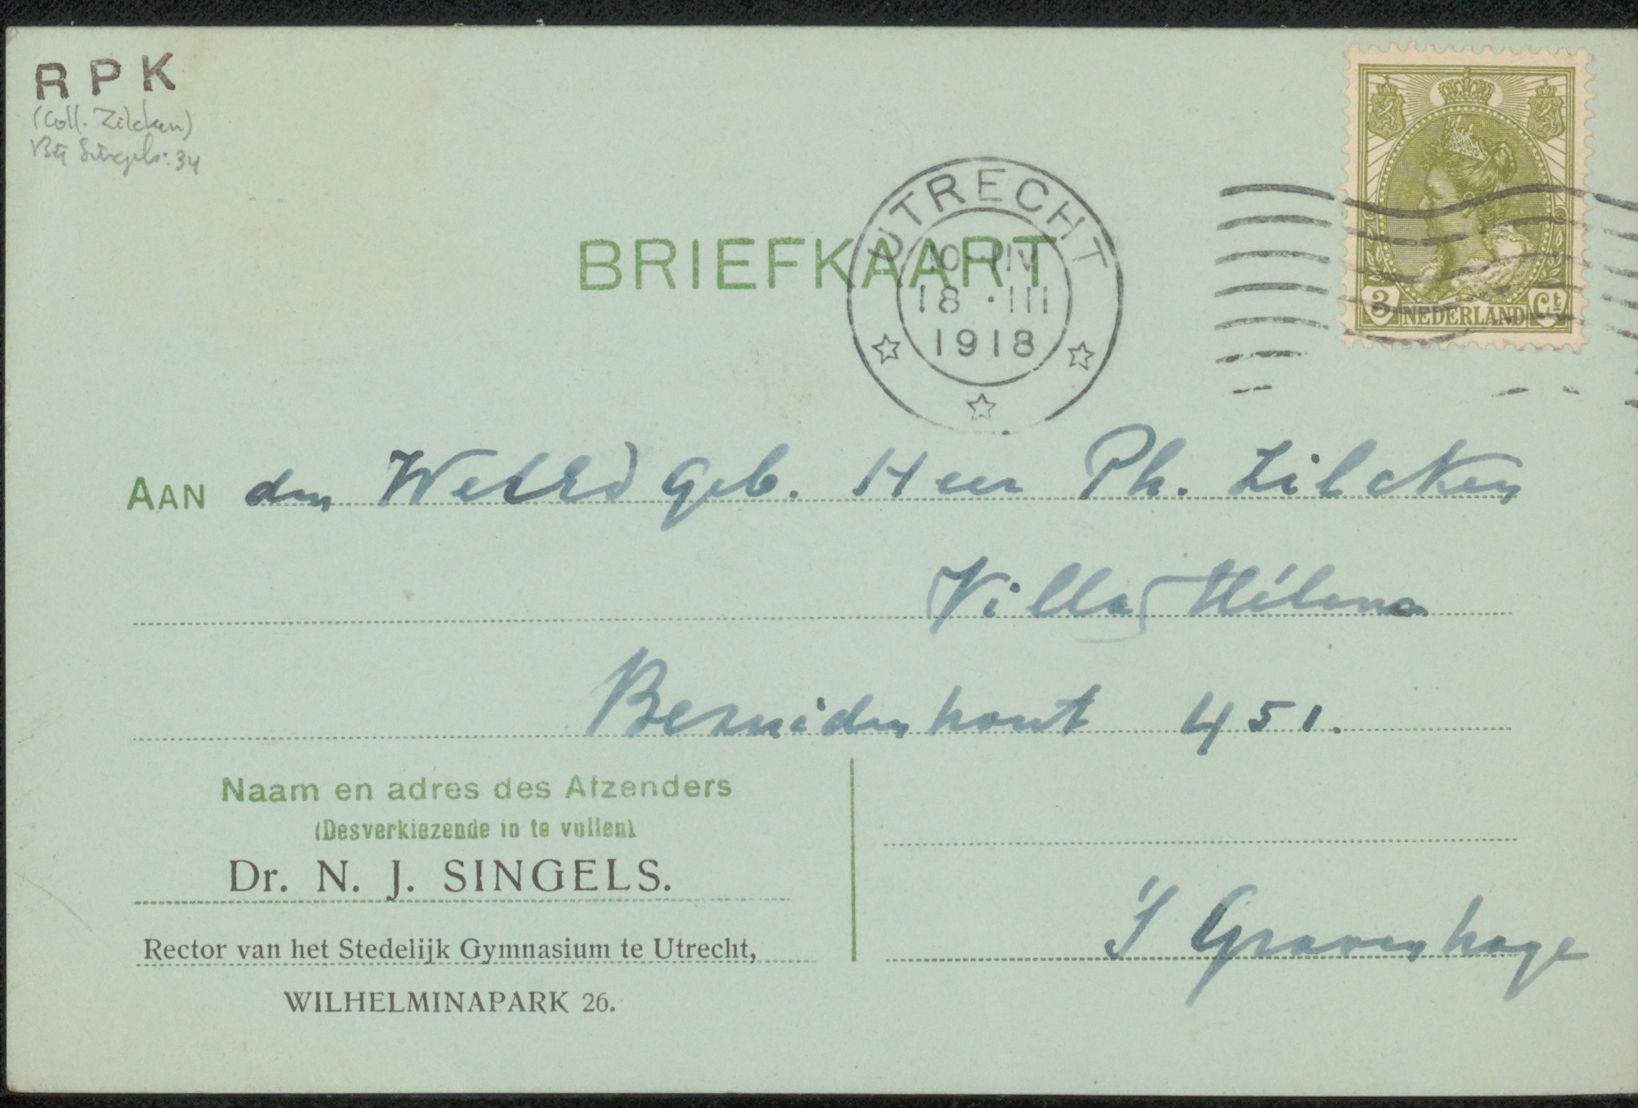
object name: postcard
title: Briefkaart aan Philip Zilcken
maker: n.j. singels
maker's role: leraar, schrijver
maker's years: 1857-1931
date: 1918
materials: cardboard, ink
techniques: pen, writing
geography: utrecht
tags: rotterdam, desiderius erasmus, georges de solpray, the hague, draughtsman, philip zilcken, printed matter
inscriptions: collector's mark: ‘RPK’